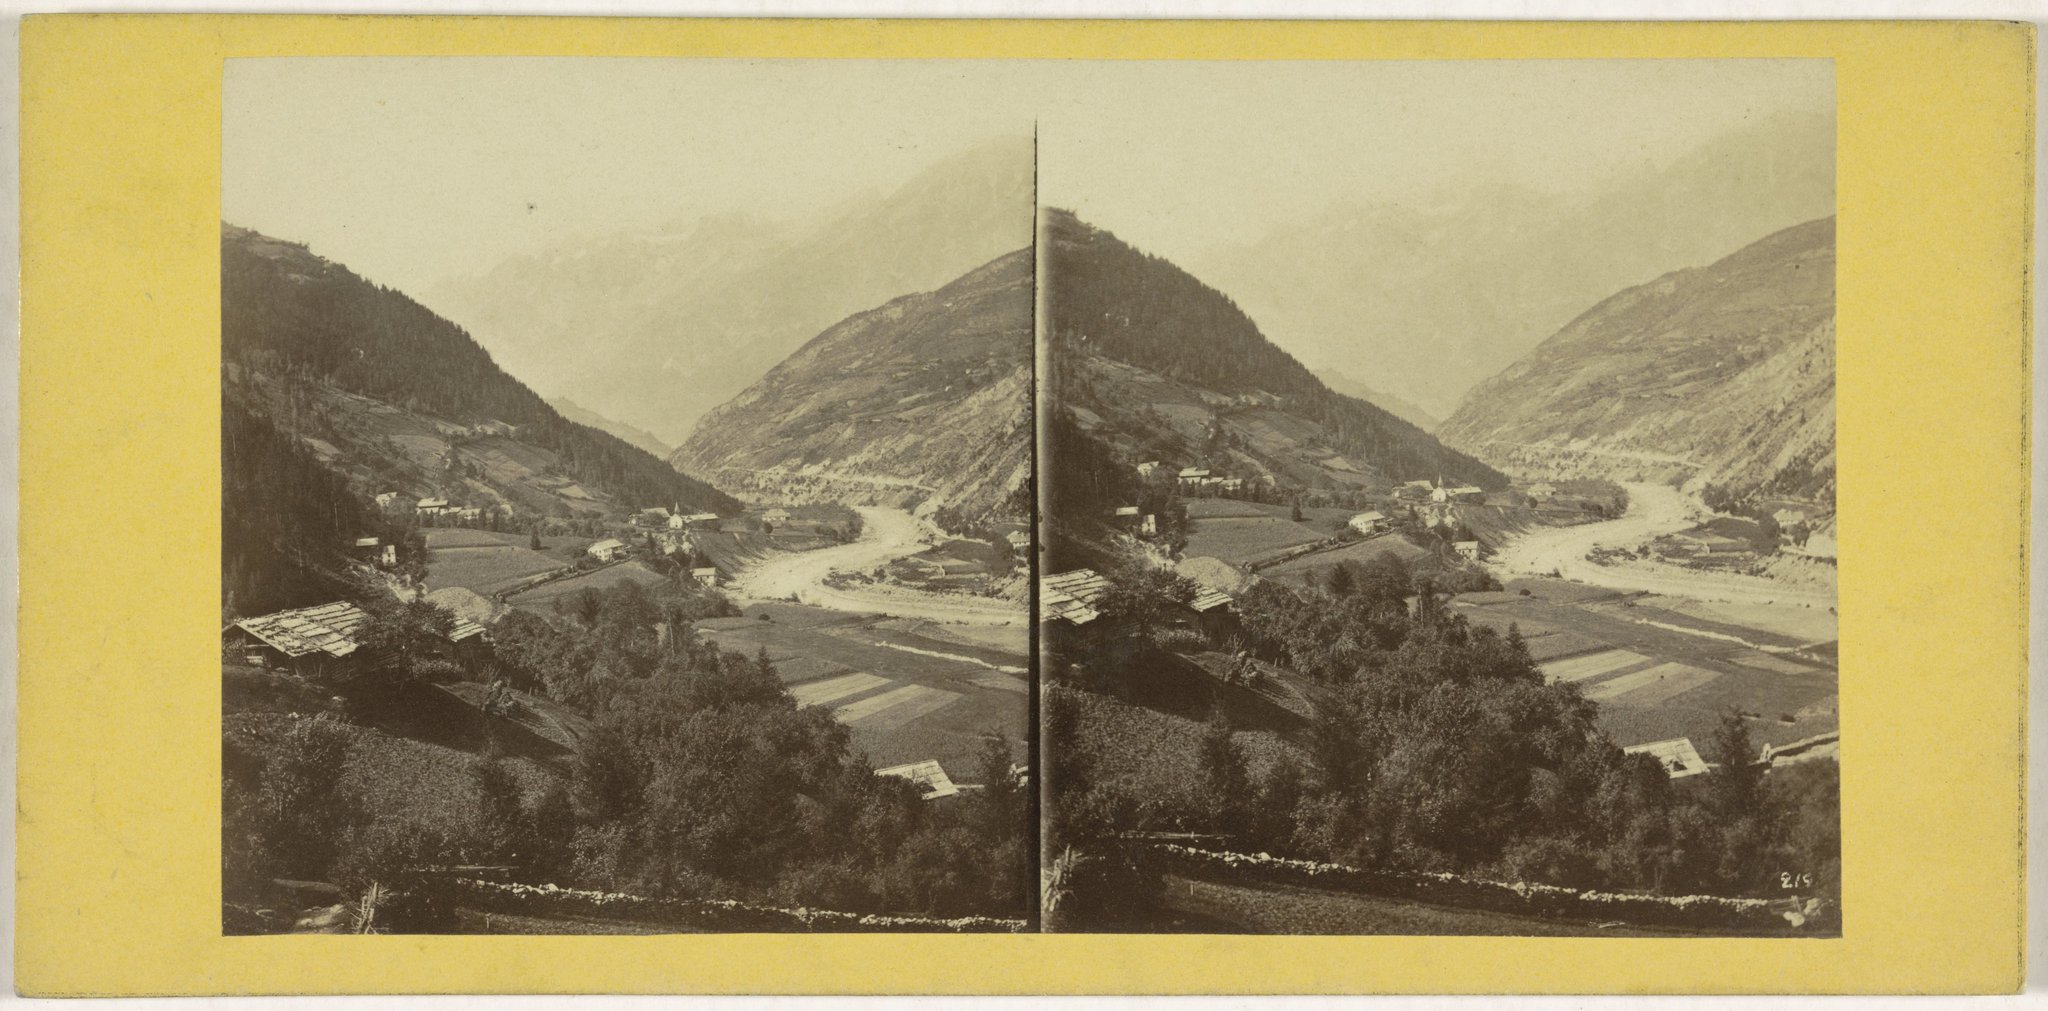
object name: stereograph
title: Gezicht op het dorp Urgen aan de Inn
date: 1861-1870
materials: cardboard, paper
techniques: albumen print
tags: prospect of village, silhouette of village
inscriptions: number: ‘219’, number: ‘No 219’, inscription: ‘U [?] 1.Y’